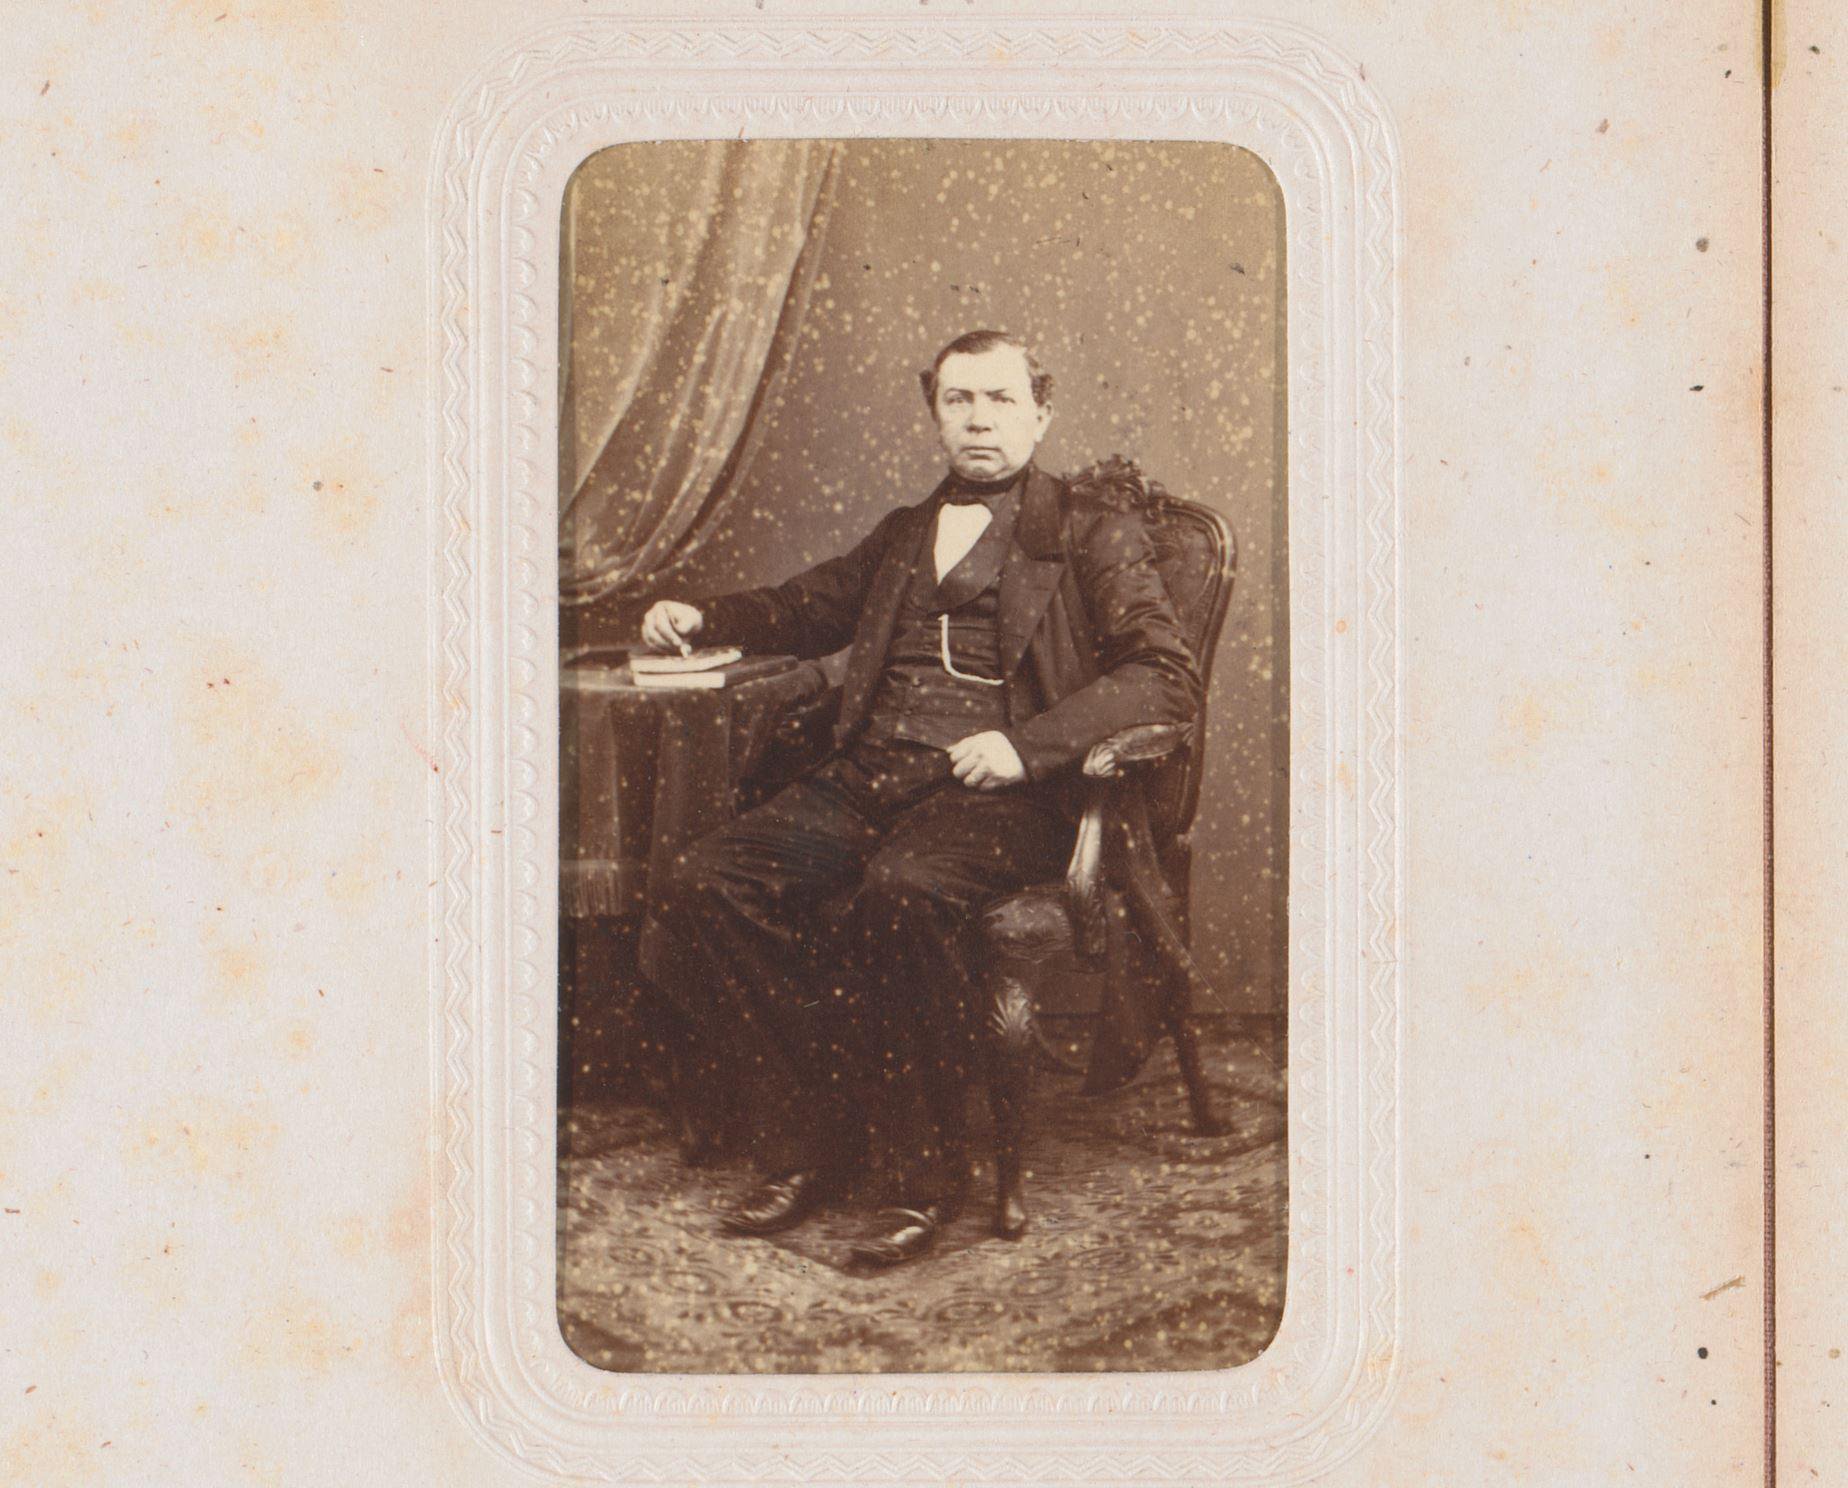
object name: album leaf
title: Portret van een man zittend aan een tafel, aangeduid als de aannemer Visser Nieuwpoort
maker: maurits verveer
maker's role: painter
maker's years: 1817-1903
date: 1855-1868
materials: cardboard, photographic support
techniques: albumen print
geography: the hague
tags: sitting figure, historical persons, table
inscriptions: name: ‘2. Visser Nieuwpoort’, inscription: ‘M. VERVEER/ PHOTOGRAPHE/ DE LL.M.M. KE ROI ET LA REINE DES PAYS-BAS./ 52, Zeestraat, vis à vis du Willemspark./ LA HAYE’